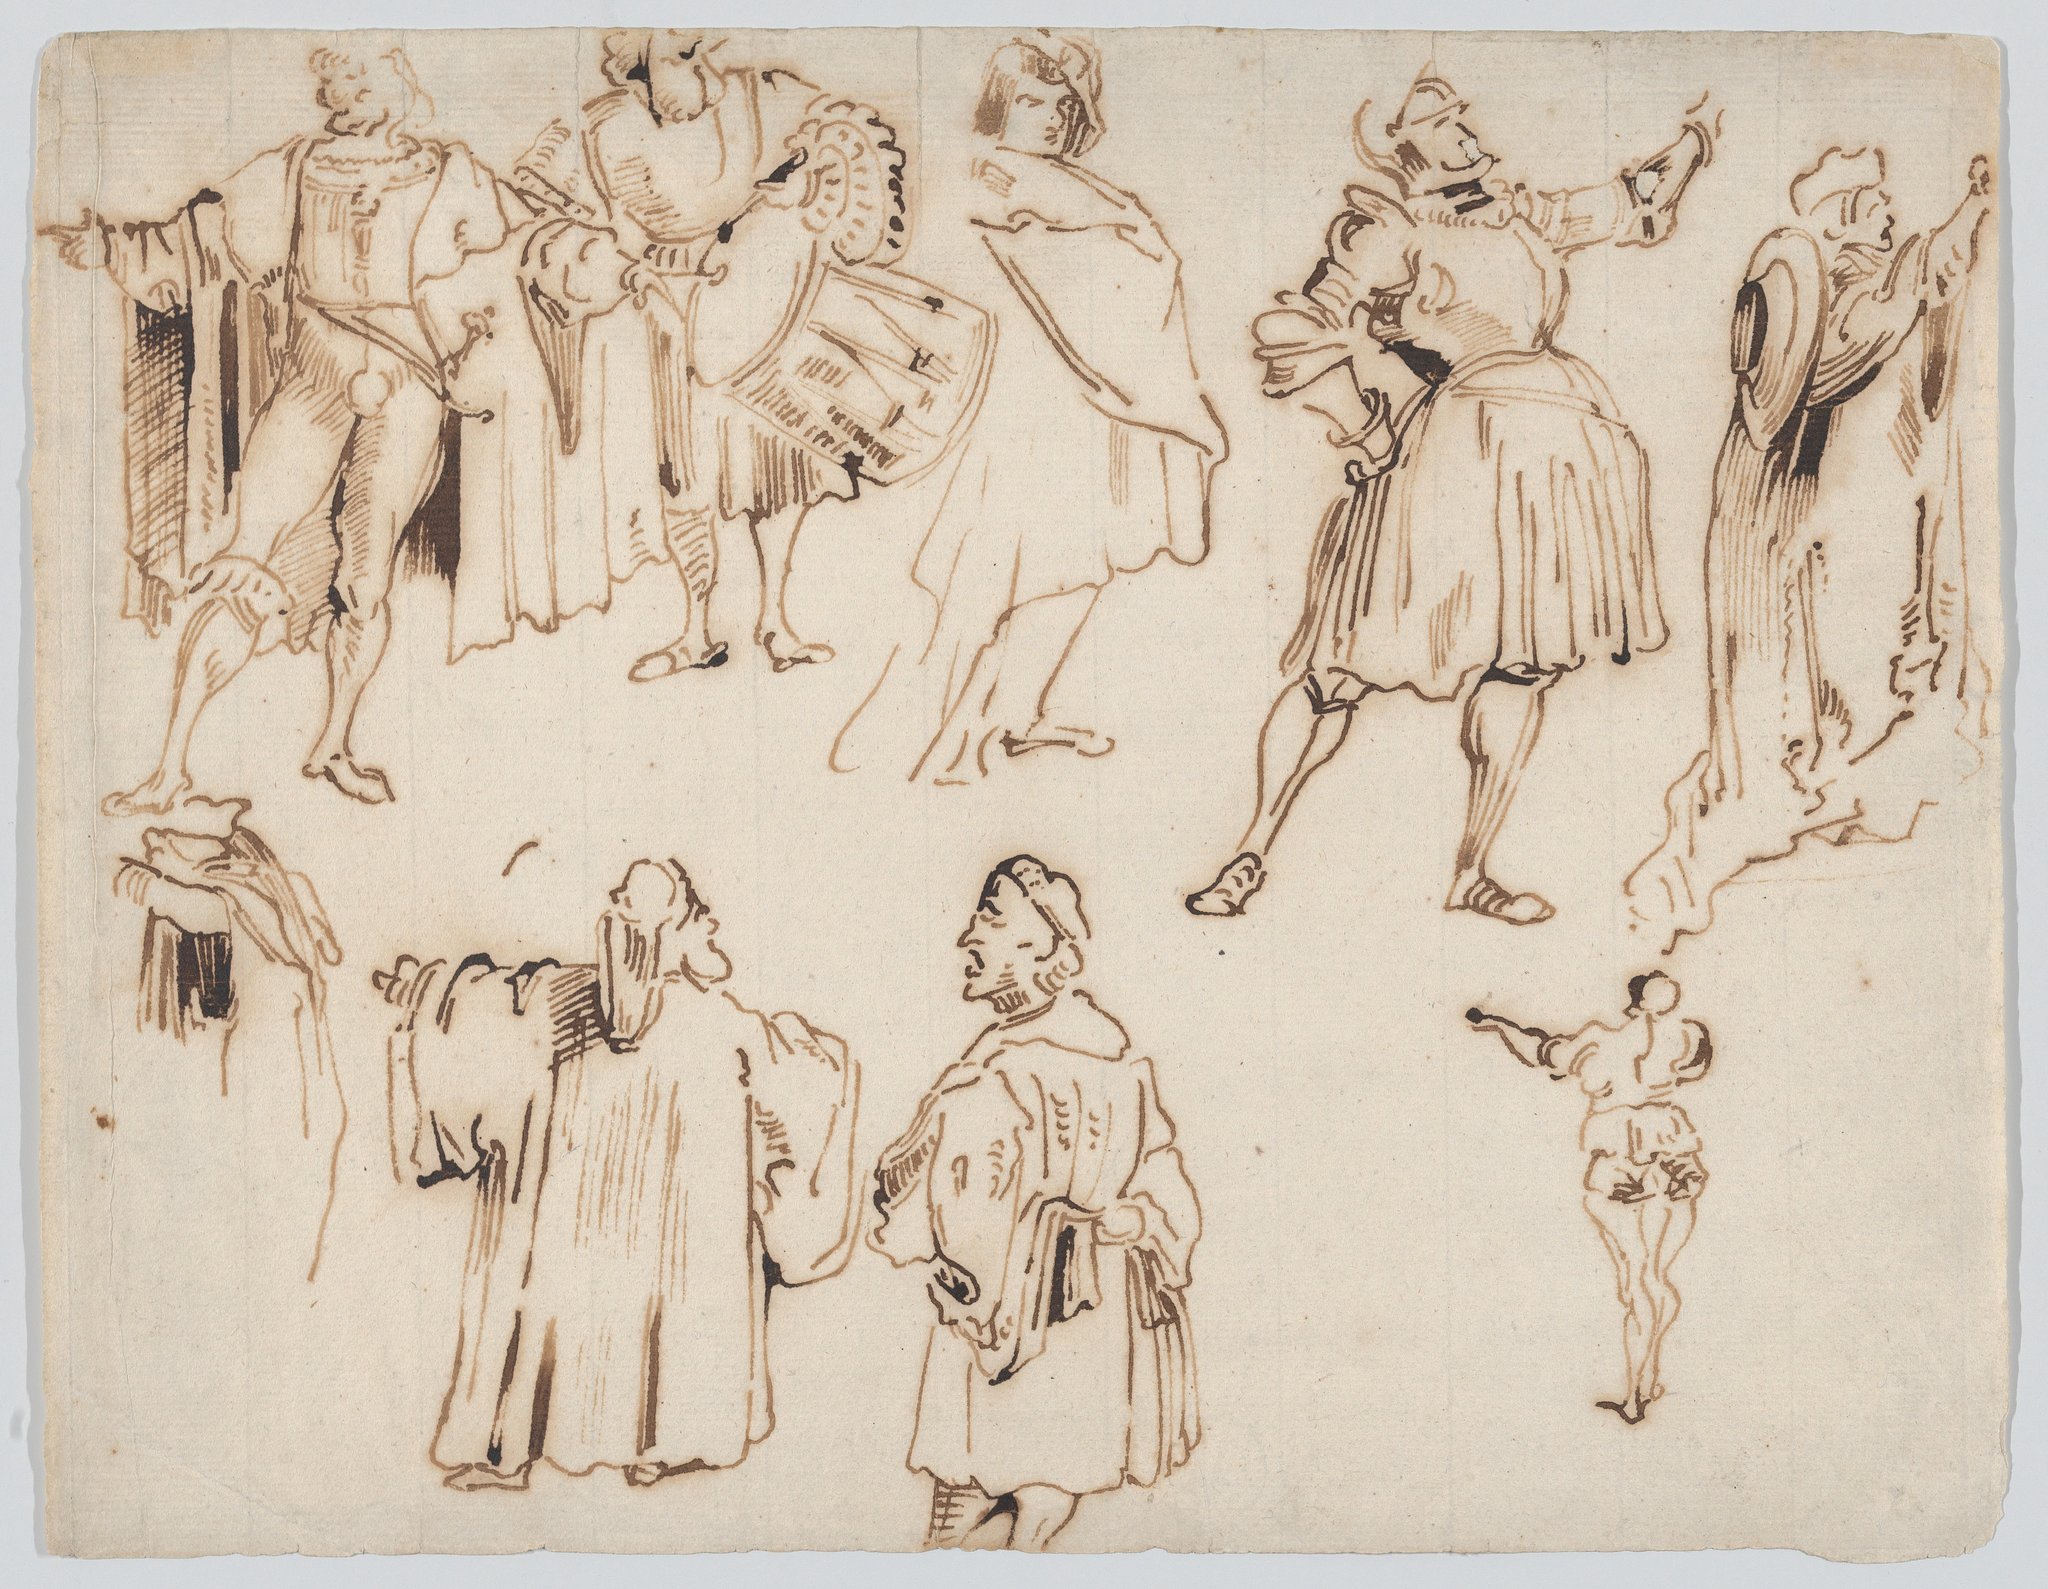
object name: drawing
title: Nine Figures in Medieval Dress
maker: eugène delacroix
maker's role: artist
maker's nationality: french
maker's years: 1798-1863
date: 1824-1827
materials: ink, iron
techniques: pen